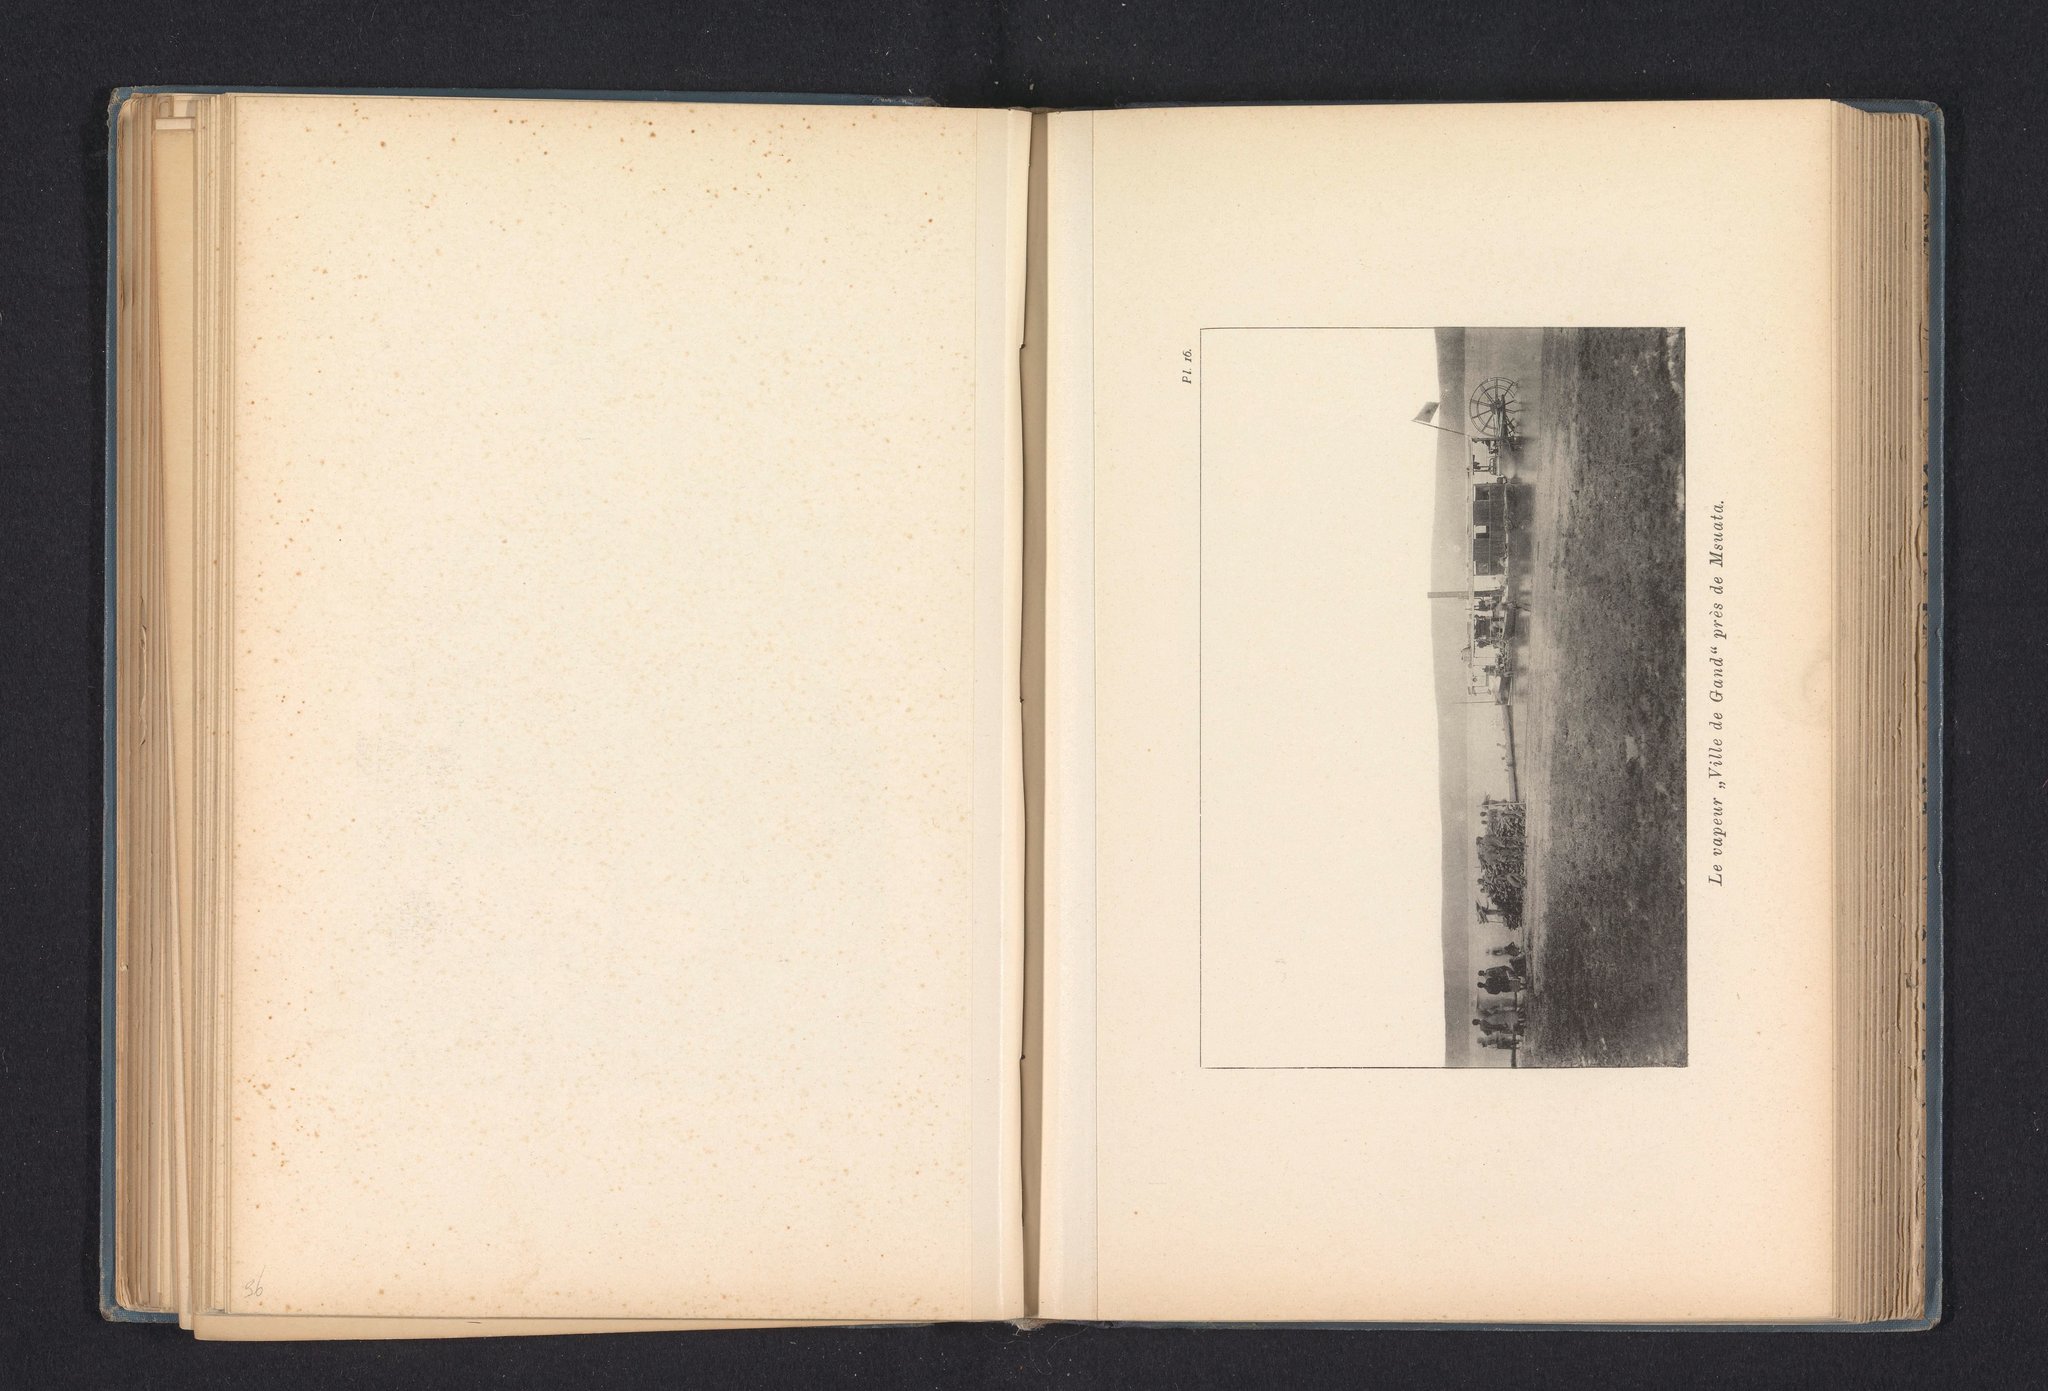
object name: photomechanical print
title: Gezicht op de stoomboot Ville de Gand nabij Msuata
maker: franz thonner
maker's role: botanicus, ontdekkingsreiziger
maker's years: 1863-1928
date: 1896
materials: paper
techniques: photograph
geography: leopoldstad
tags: steamship, motorship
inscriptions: number: ‘Pl. 16.’